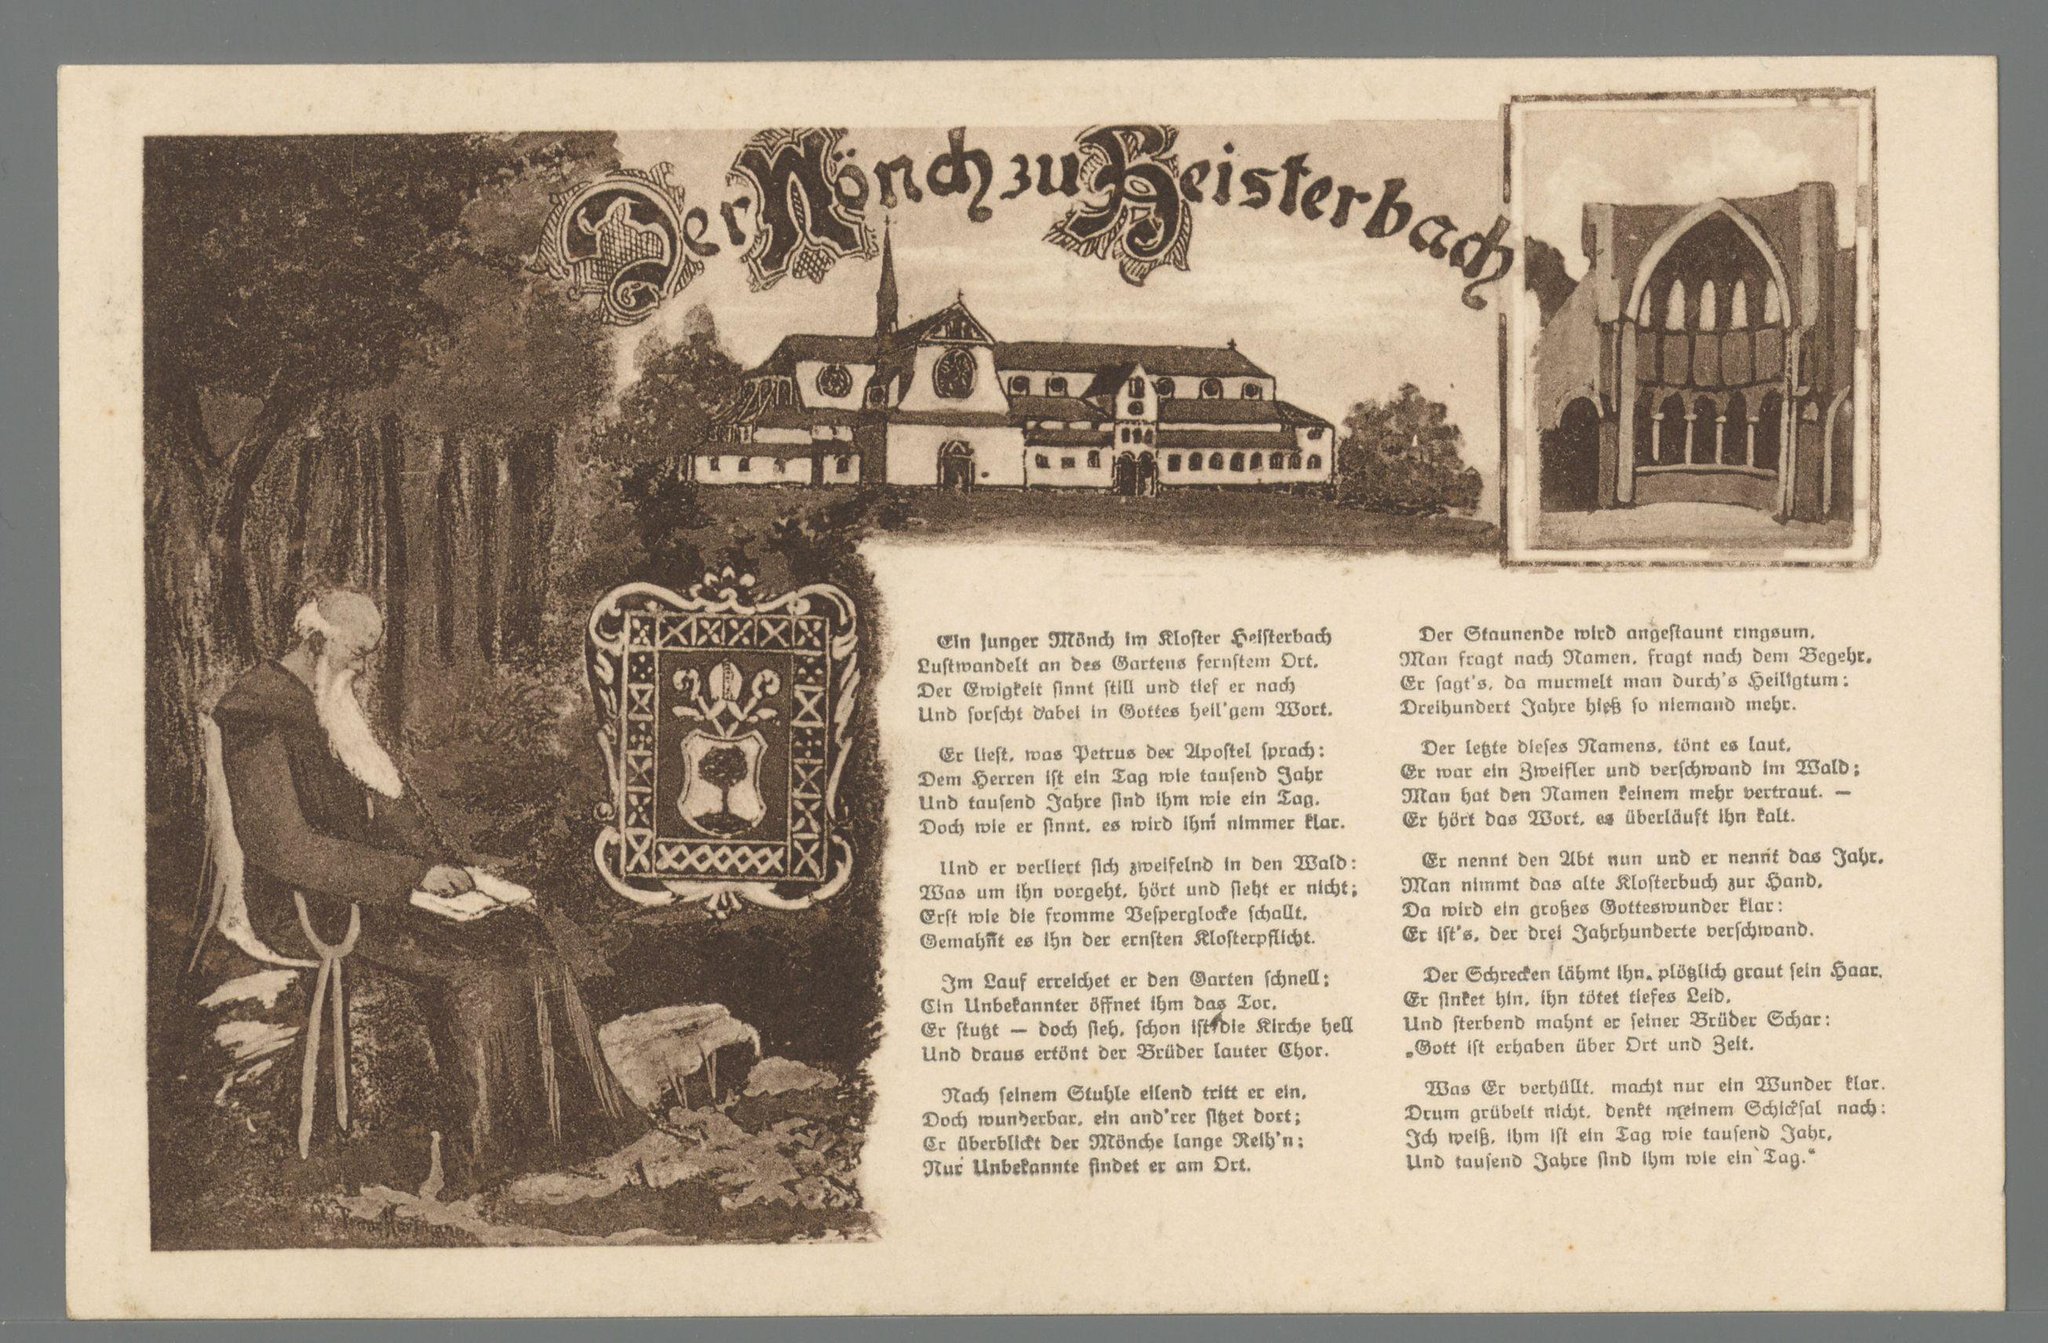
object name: ansichtkaart, prentbriefkaart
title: Der Mönch zu Heisterbach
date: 1905-1930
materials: cardboard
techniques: photograph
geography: königswinter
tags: coat of arms (as symbol of the state, etc.), abbey, monastery, convent ~ roman catholic church, monk(s), friar(s)